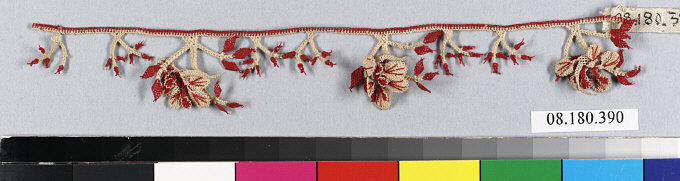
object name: fragment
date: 1801-1900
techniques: lace